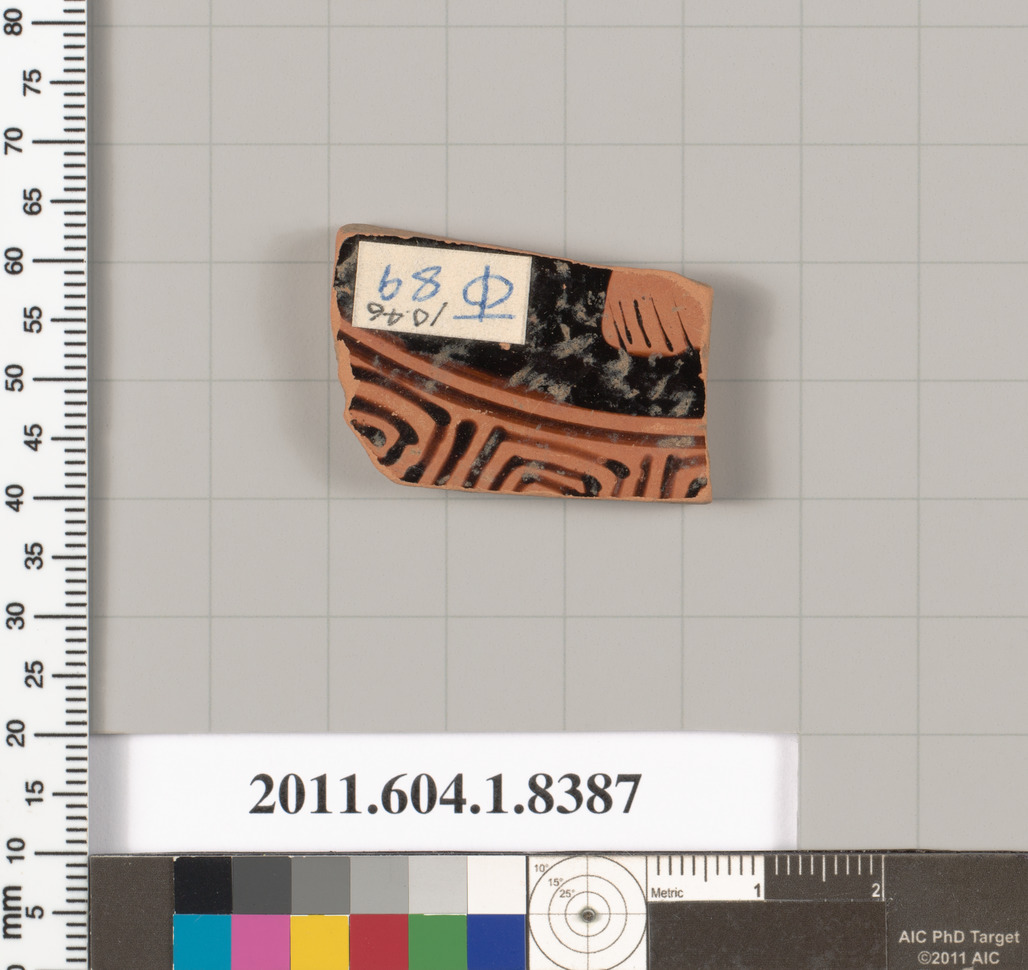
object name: kylix fragment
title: Terracotta fragment of a kylix (drinking cup)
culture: greek, attic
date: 375-351 BCE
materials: terracotta